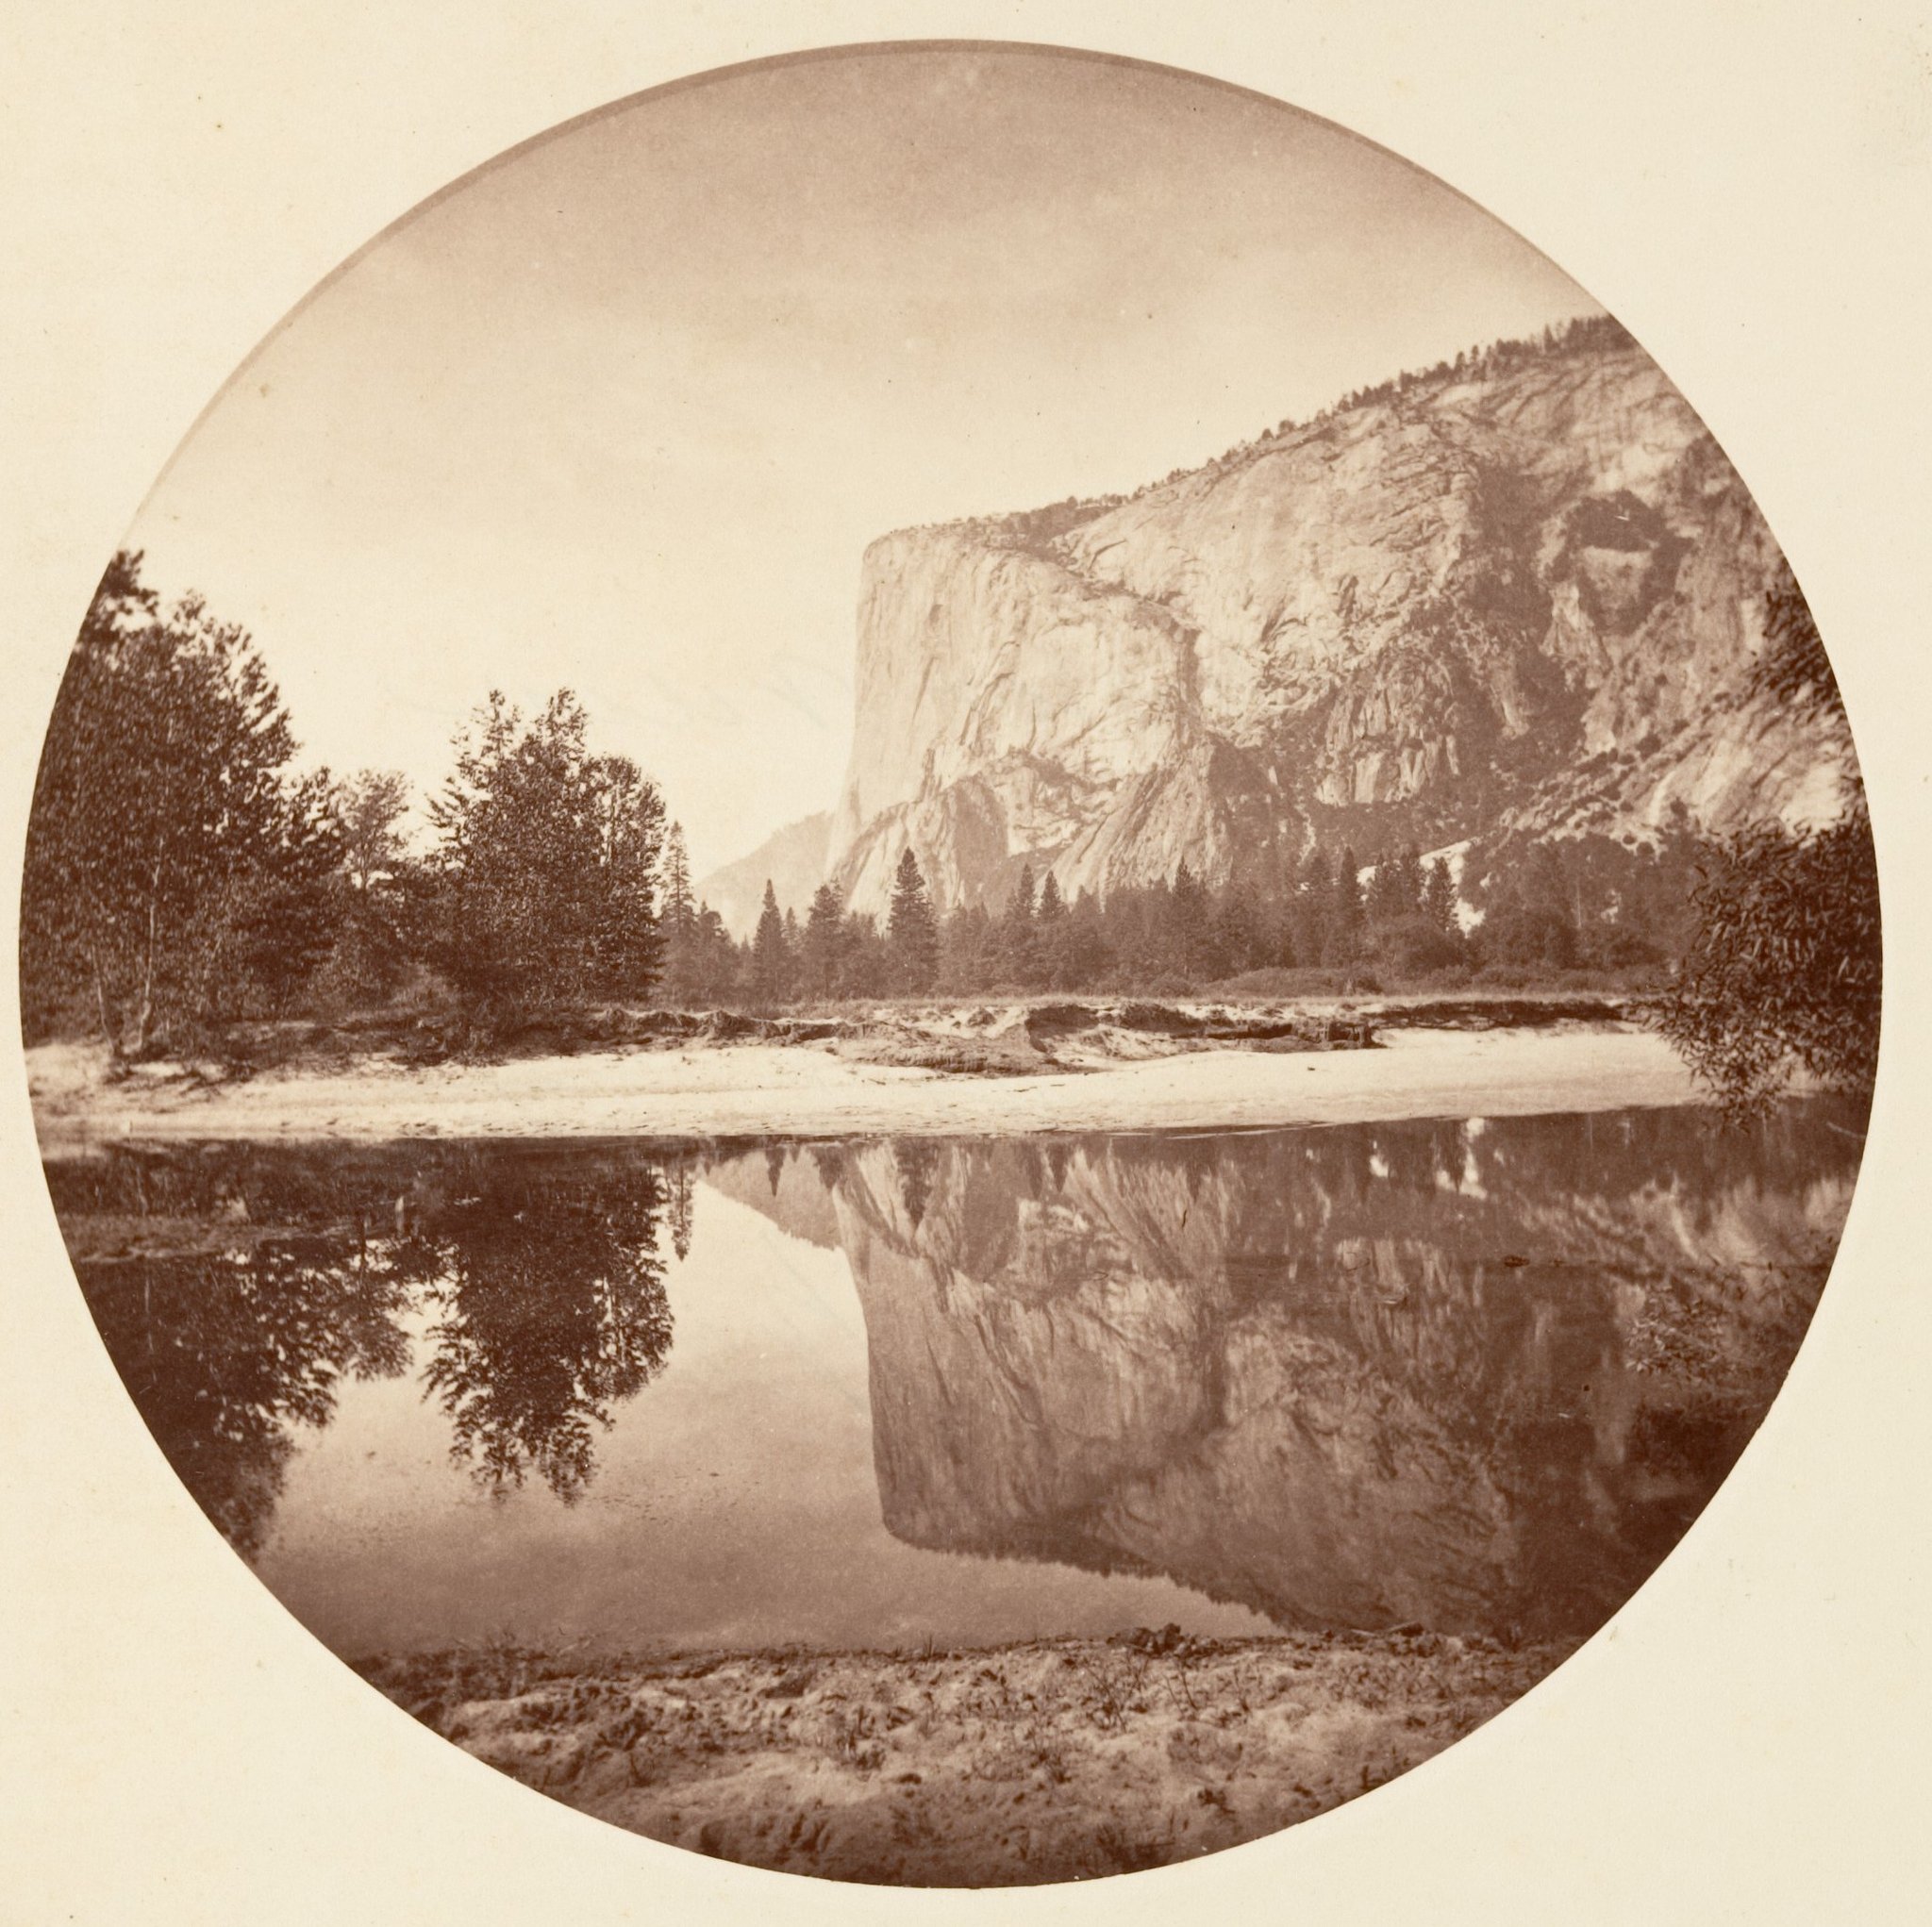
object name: photograph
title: [Yosemite National Park, California]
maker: carleton e. watkins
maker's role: artist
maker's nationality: american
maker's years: 1829-1916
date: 1878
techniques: albumen silver print, glass negative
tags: mountains,landscapes